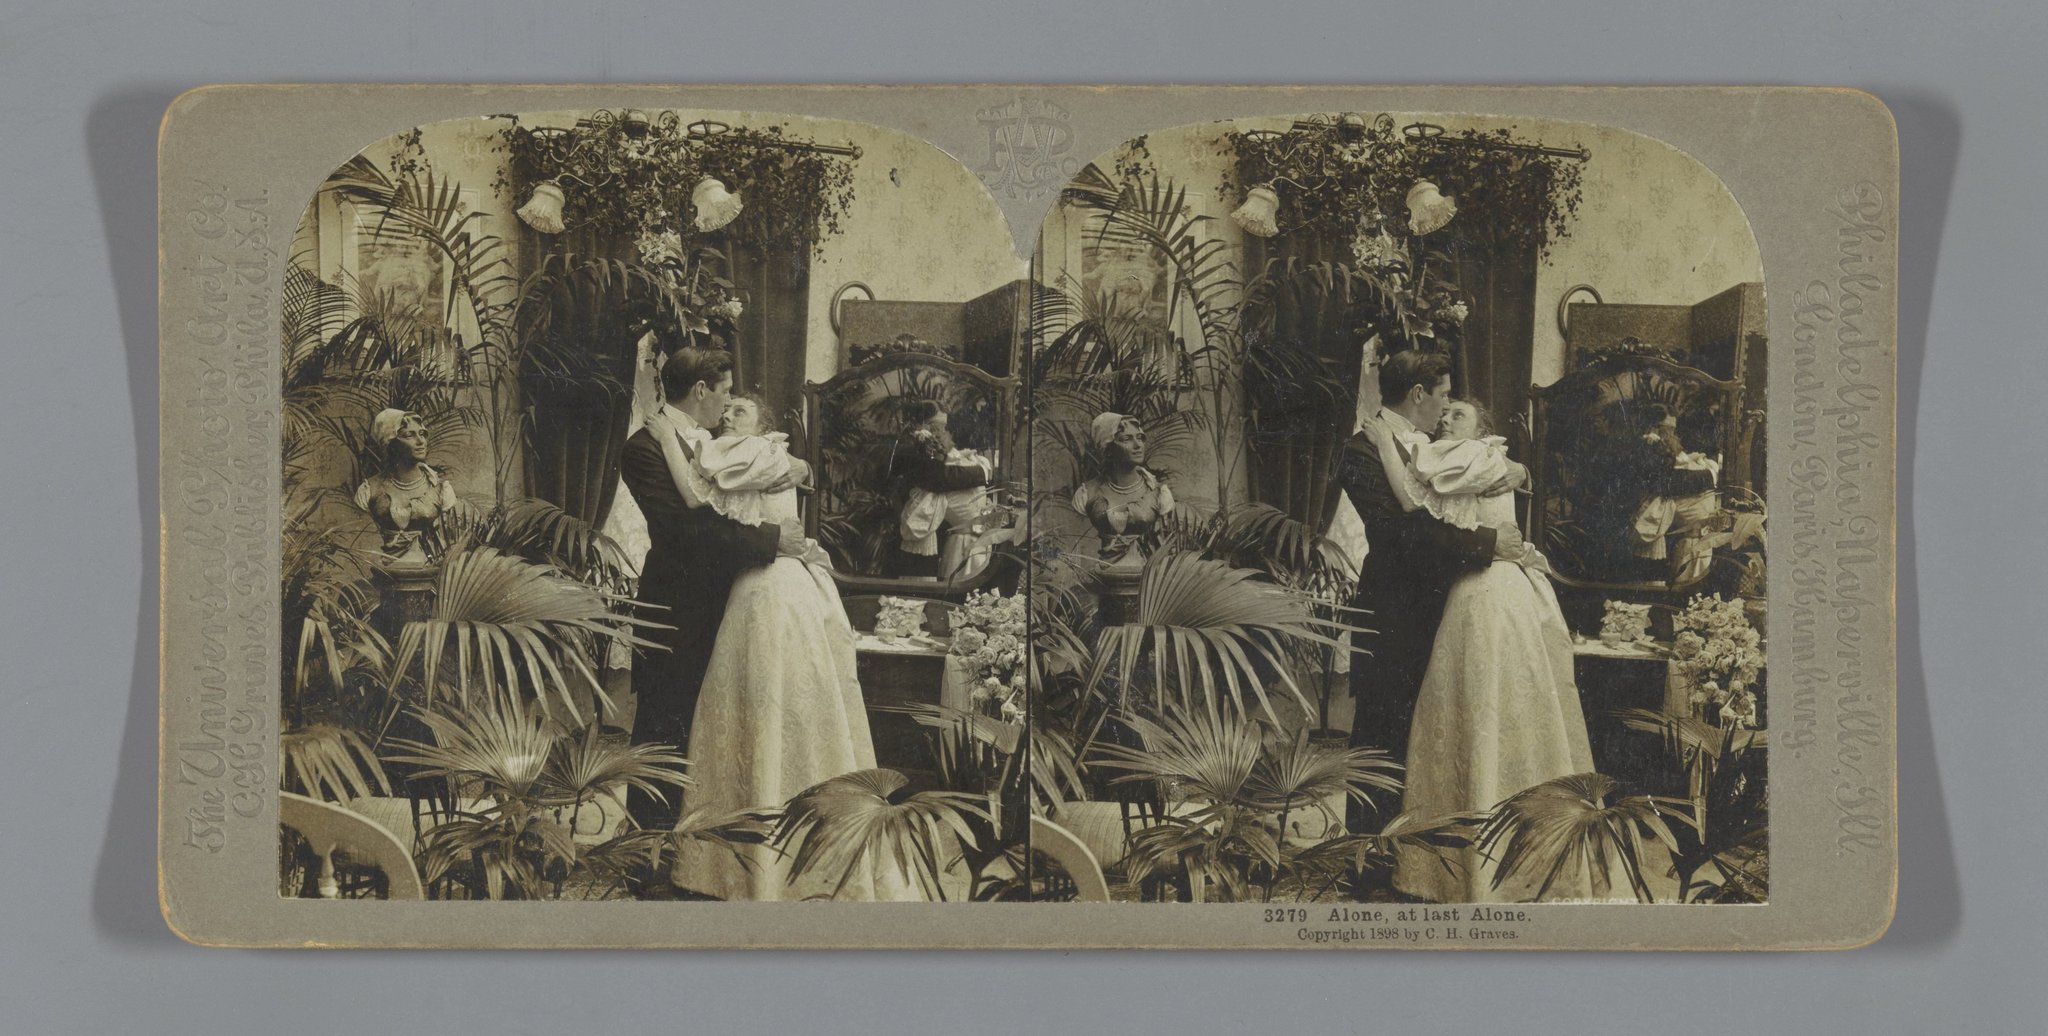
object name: stereograph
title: Paar in omhelzing in ruimte met planten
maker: carleton harlow graves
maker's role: fotograaf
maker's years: 1867-1943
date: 1898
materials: cardboard, photographic support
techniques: gelatin silver print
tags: couple of lovers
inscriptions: number: ‘58’, : ‘Copyright 1898 by C.H. Graves’, check stamp: ‘Philadelphia, Naperville, Ill. / London, Paris, Hamburg’, number: ‘3279’